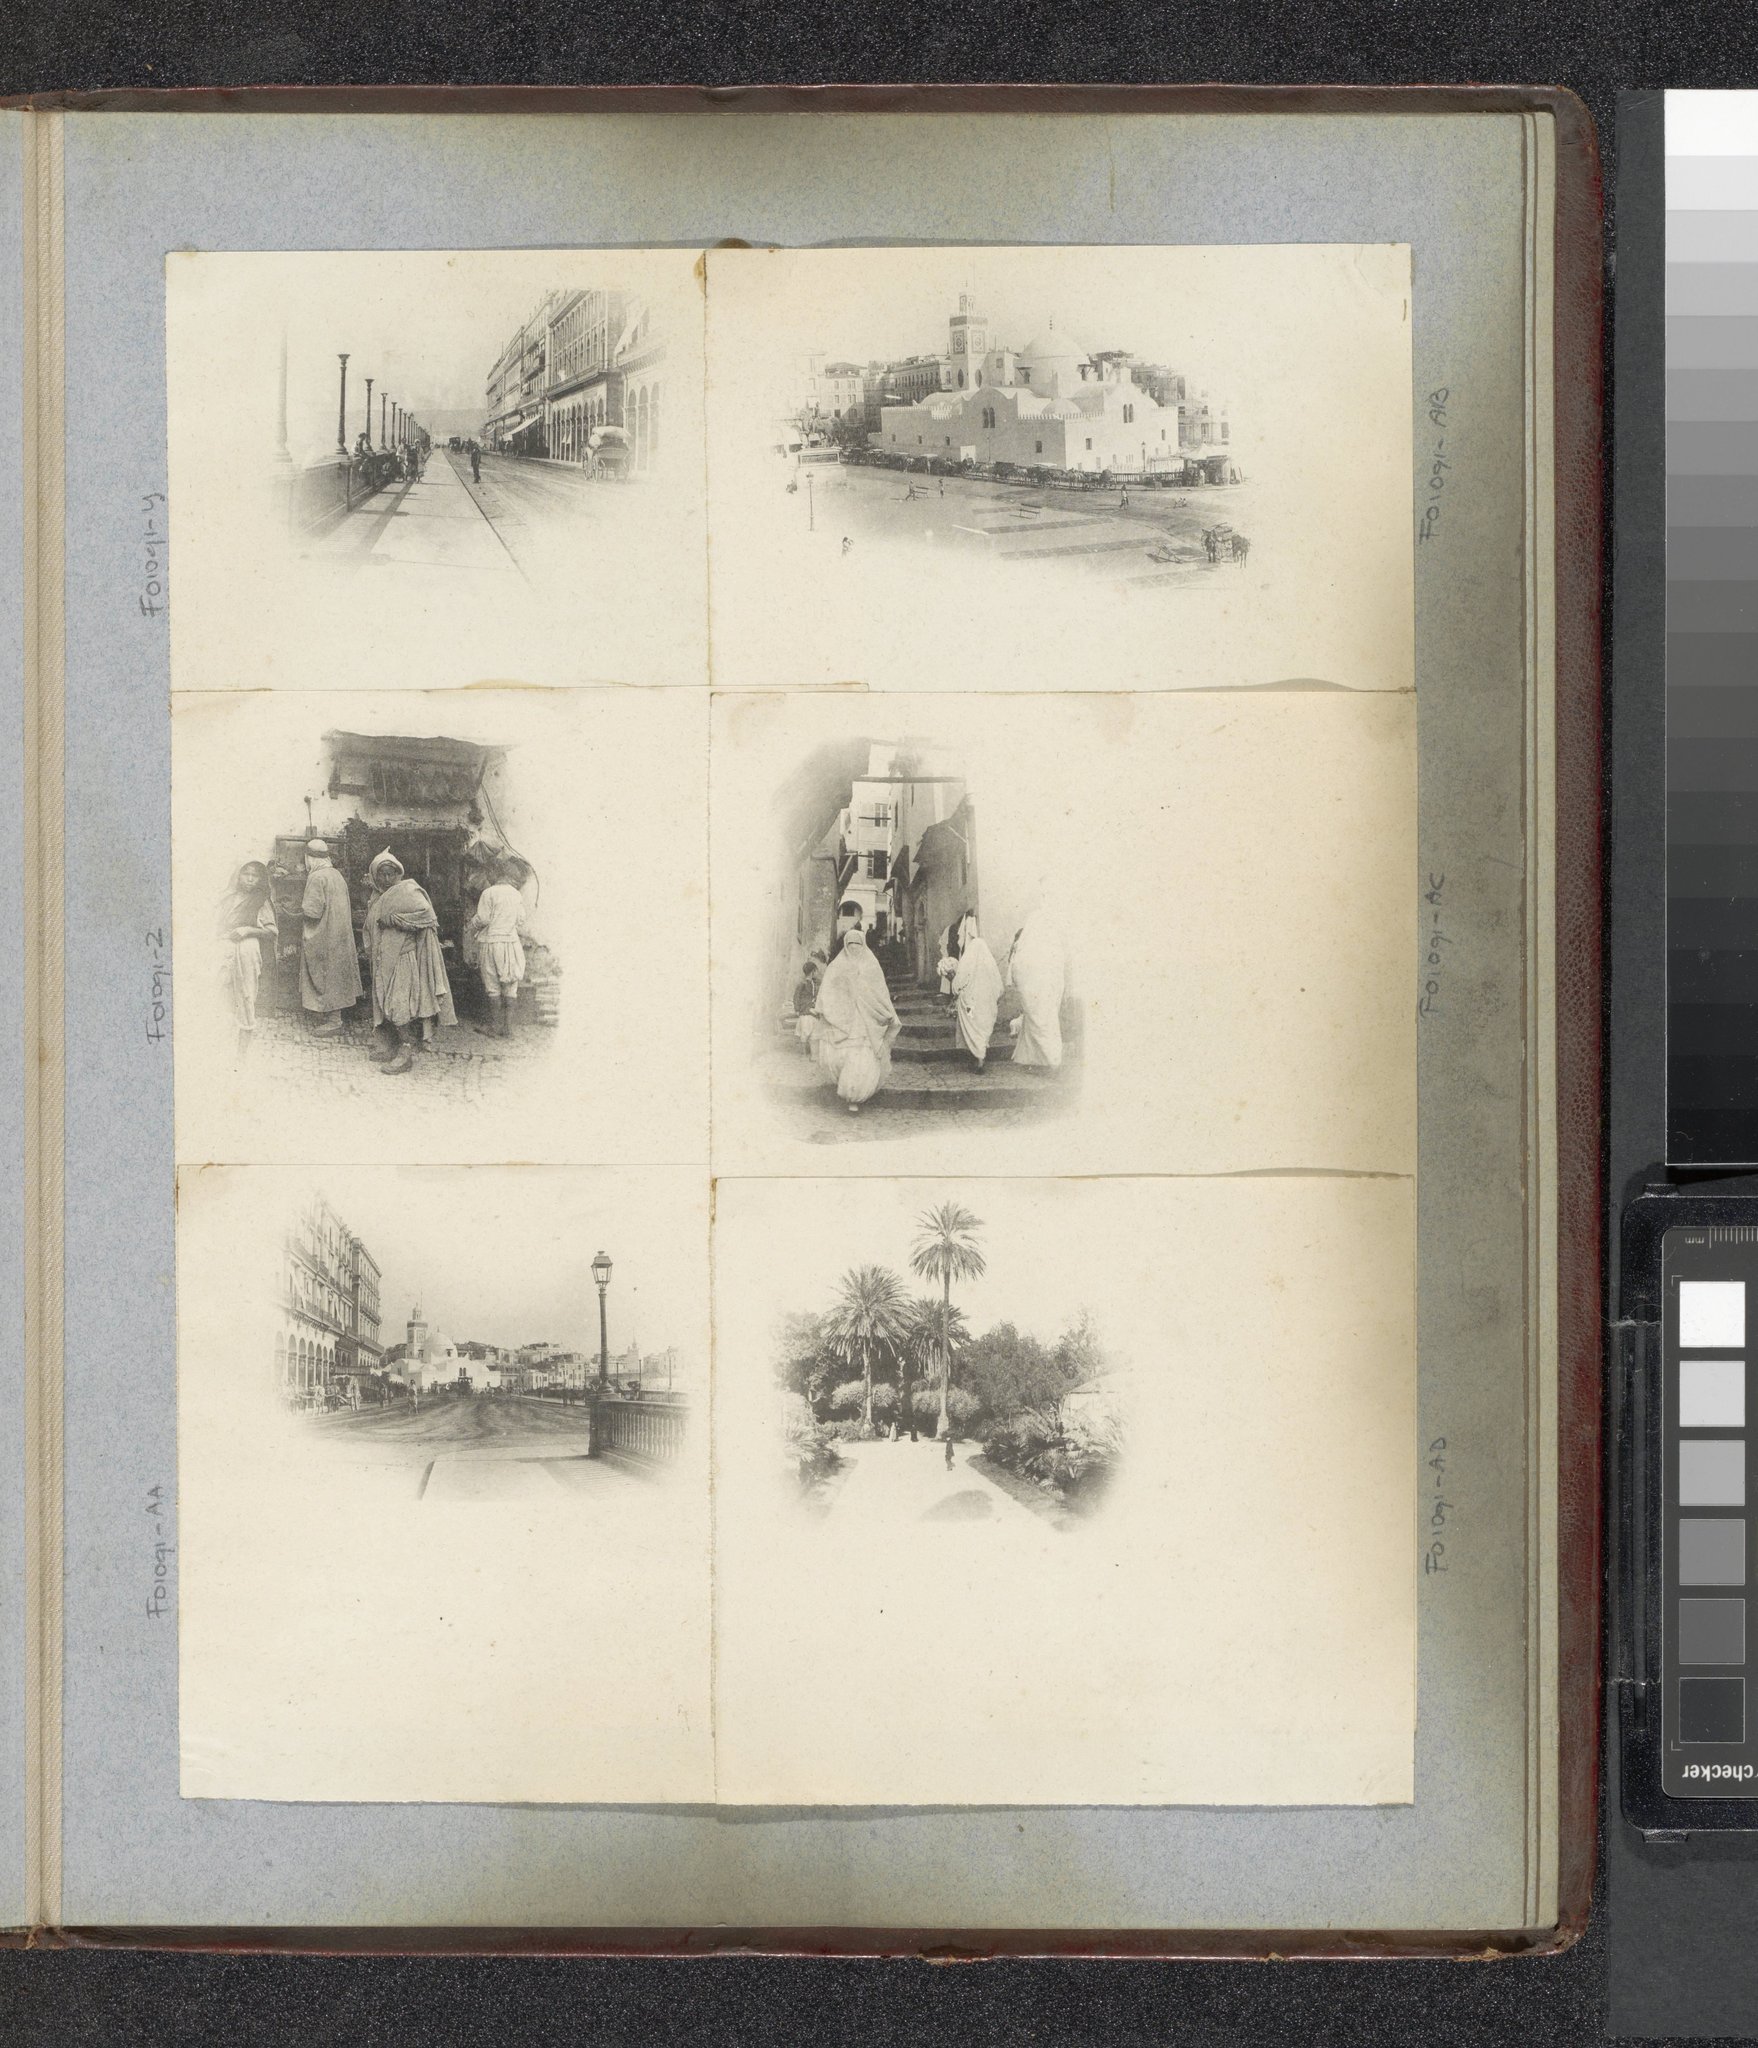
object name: album leaf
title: Mensen bij een winkel in Tunesië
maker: Anonymous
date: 1880-1900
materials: paper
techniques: photograph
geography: tunisia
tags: shop, store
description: Onderdeel van Reisalbum met foto's van bezienswaardigheden in Tunis en Tunesië.